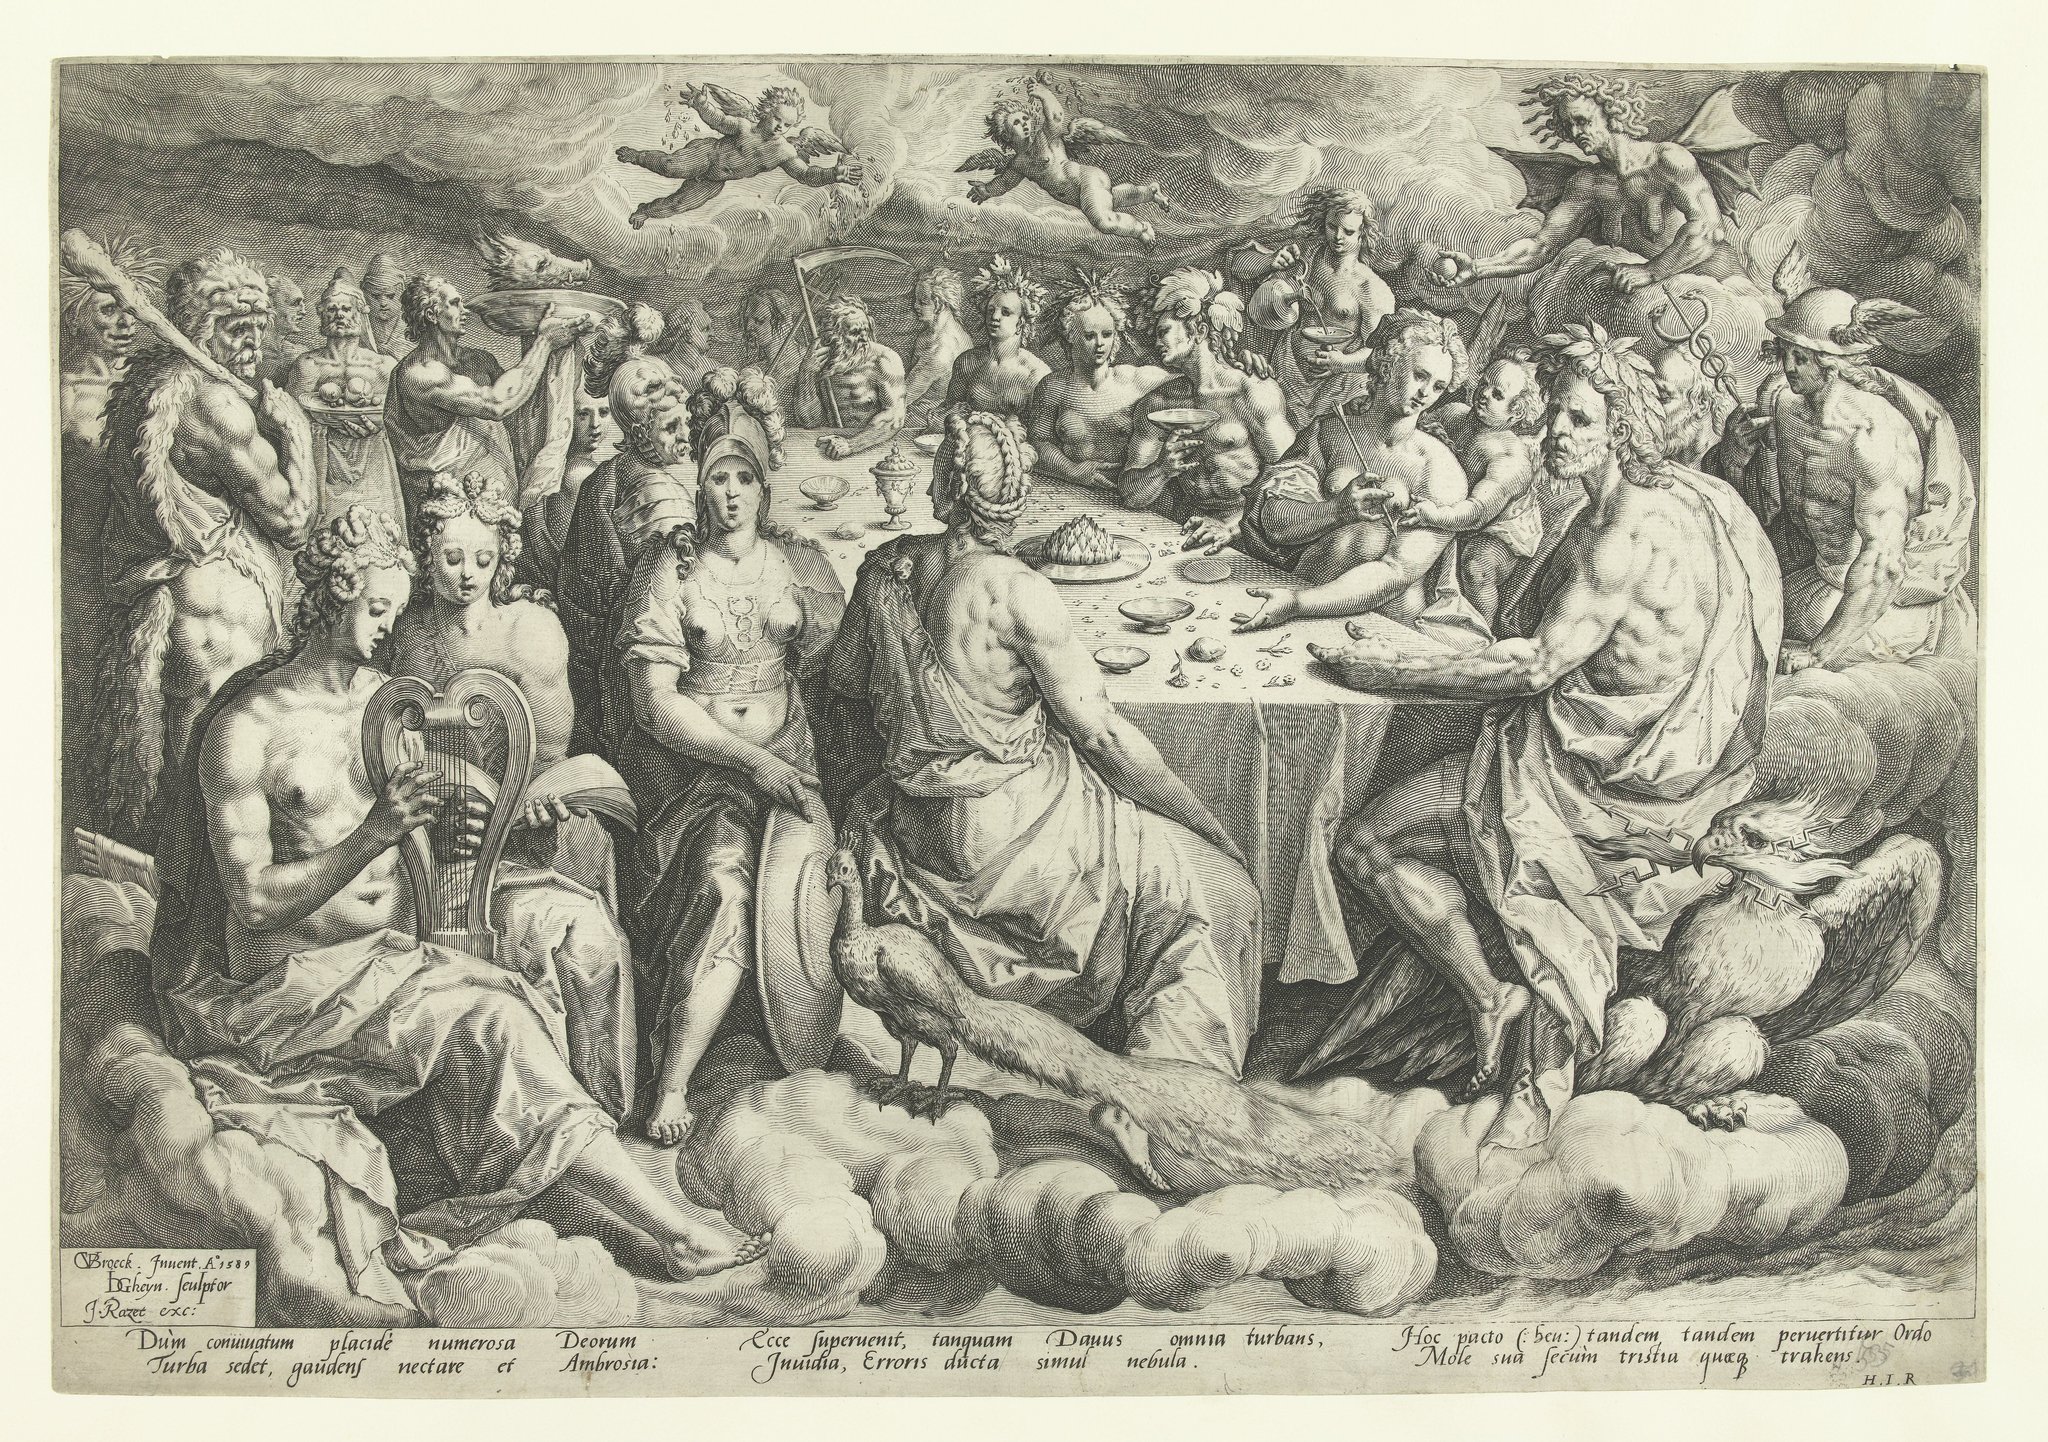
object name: print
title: Godenbanket tijdens de bruiloft van Peleus en Thetis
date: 1589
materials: paper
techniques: engraving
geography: netherlands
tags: the marriage-feast of peleus and thetis in the clouds, eris throws the golden apple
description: Temidden van de wolken gebruiken godenfiguren aan een lange tafel de maaltijd. Aan het hoofd, op de voorgrond, zitten Jupiter en Juno, herkenbaar aan respectievelijk de adelaar met de bliksemschichten en de pauw. Rechts op de achtergrond biedt Eris, de godin van de twist, de gouden appel aan de gasten aan. Onder de voorstelling zes regels Latijnse tekst.